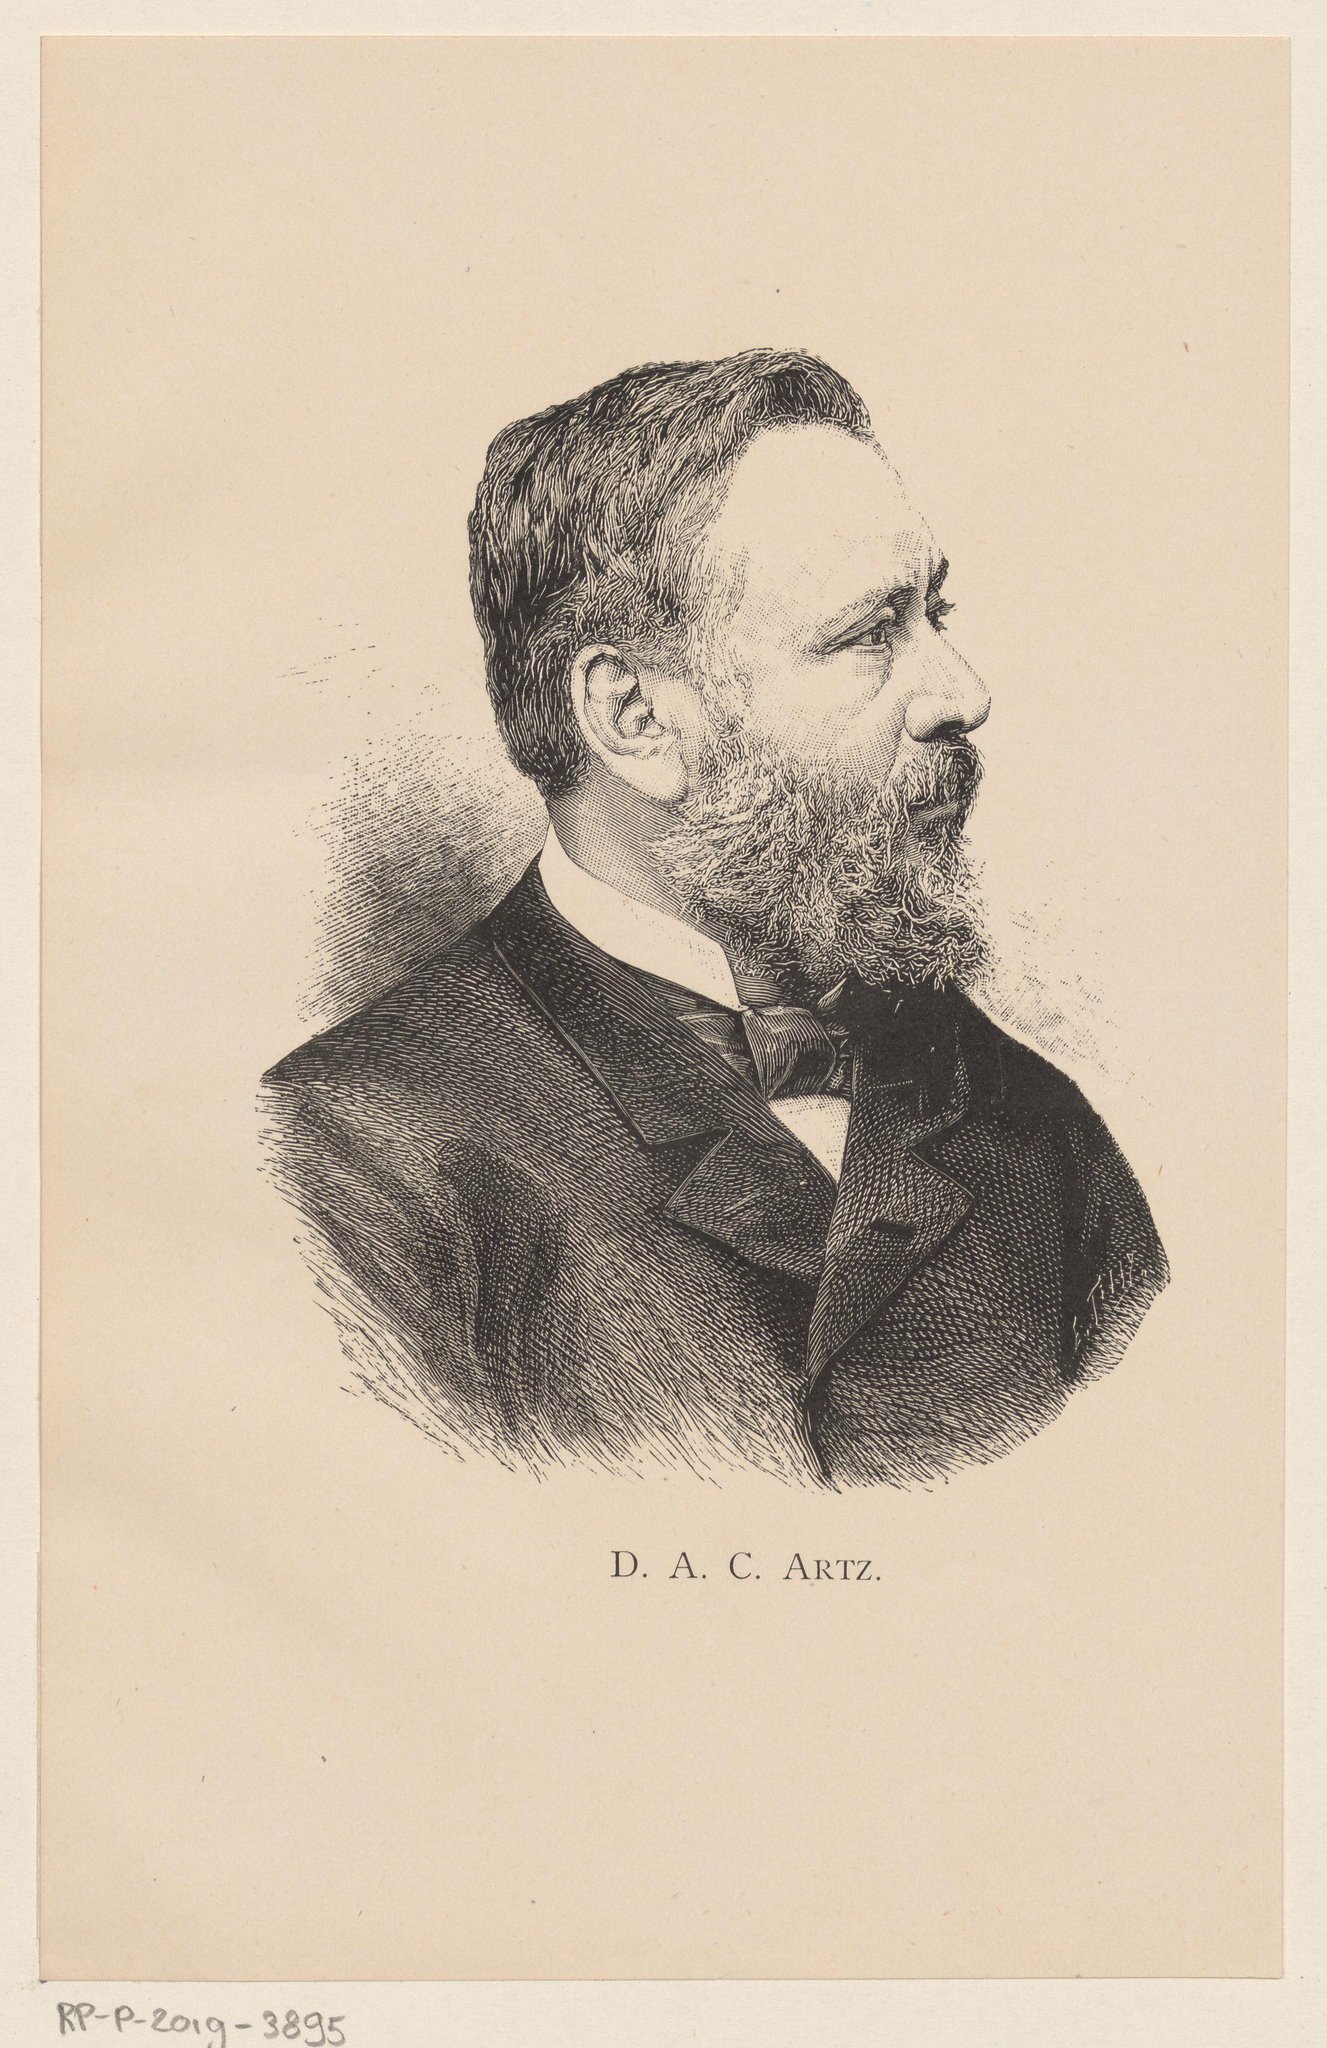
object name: print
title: Portret van David Adolph Constant Artz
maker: Anonymous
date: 1890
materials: paper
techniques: engraving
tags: draughtsman, david adolph constant artz, historical persons, portrait, self-portrait of painter